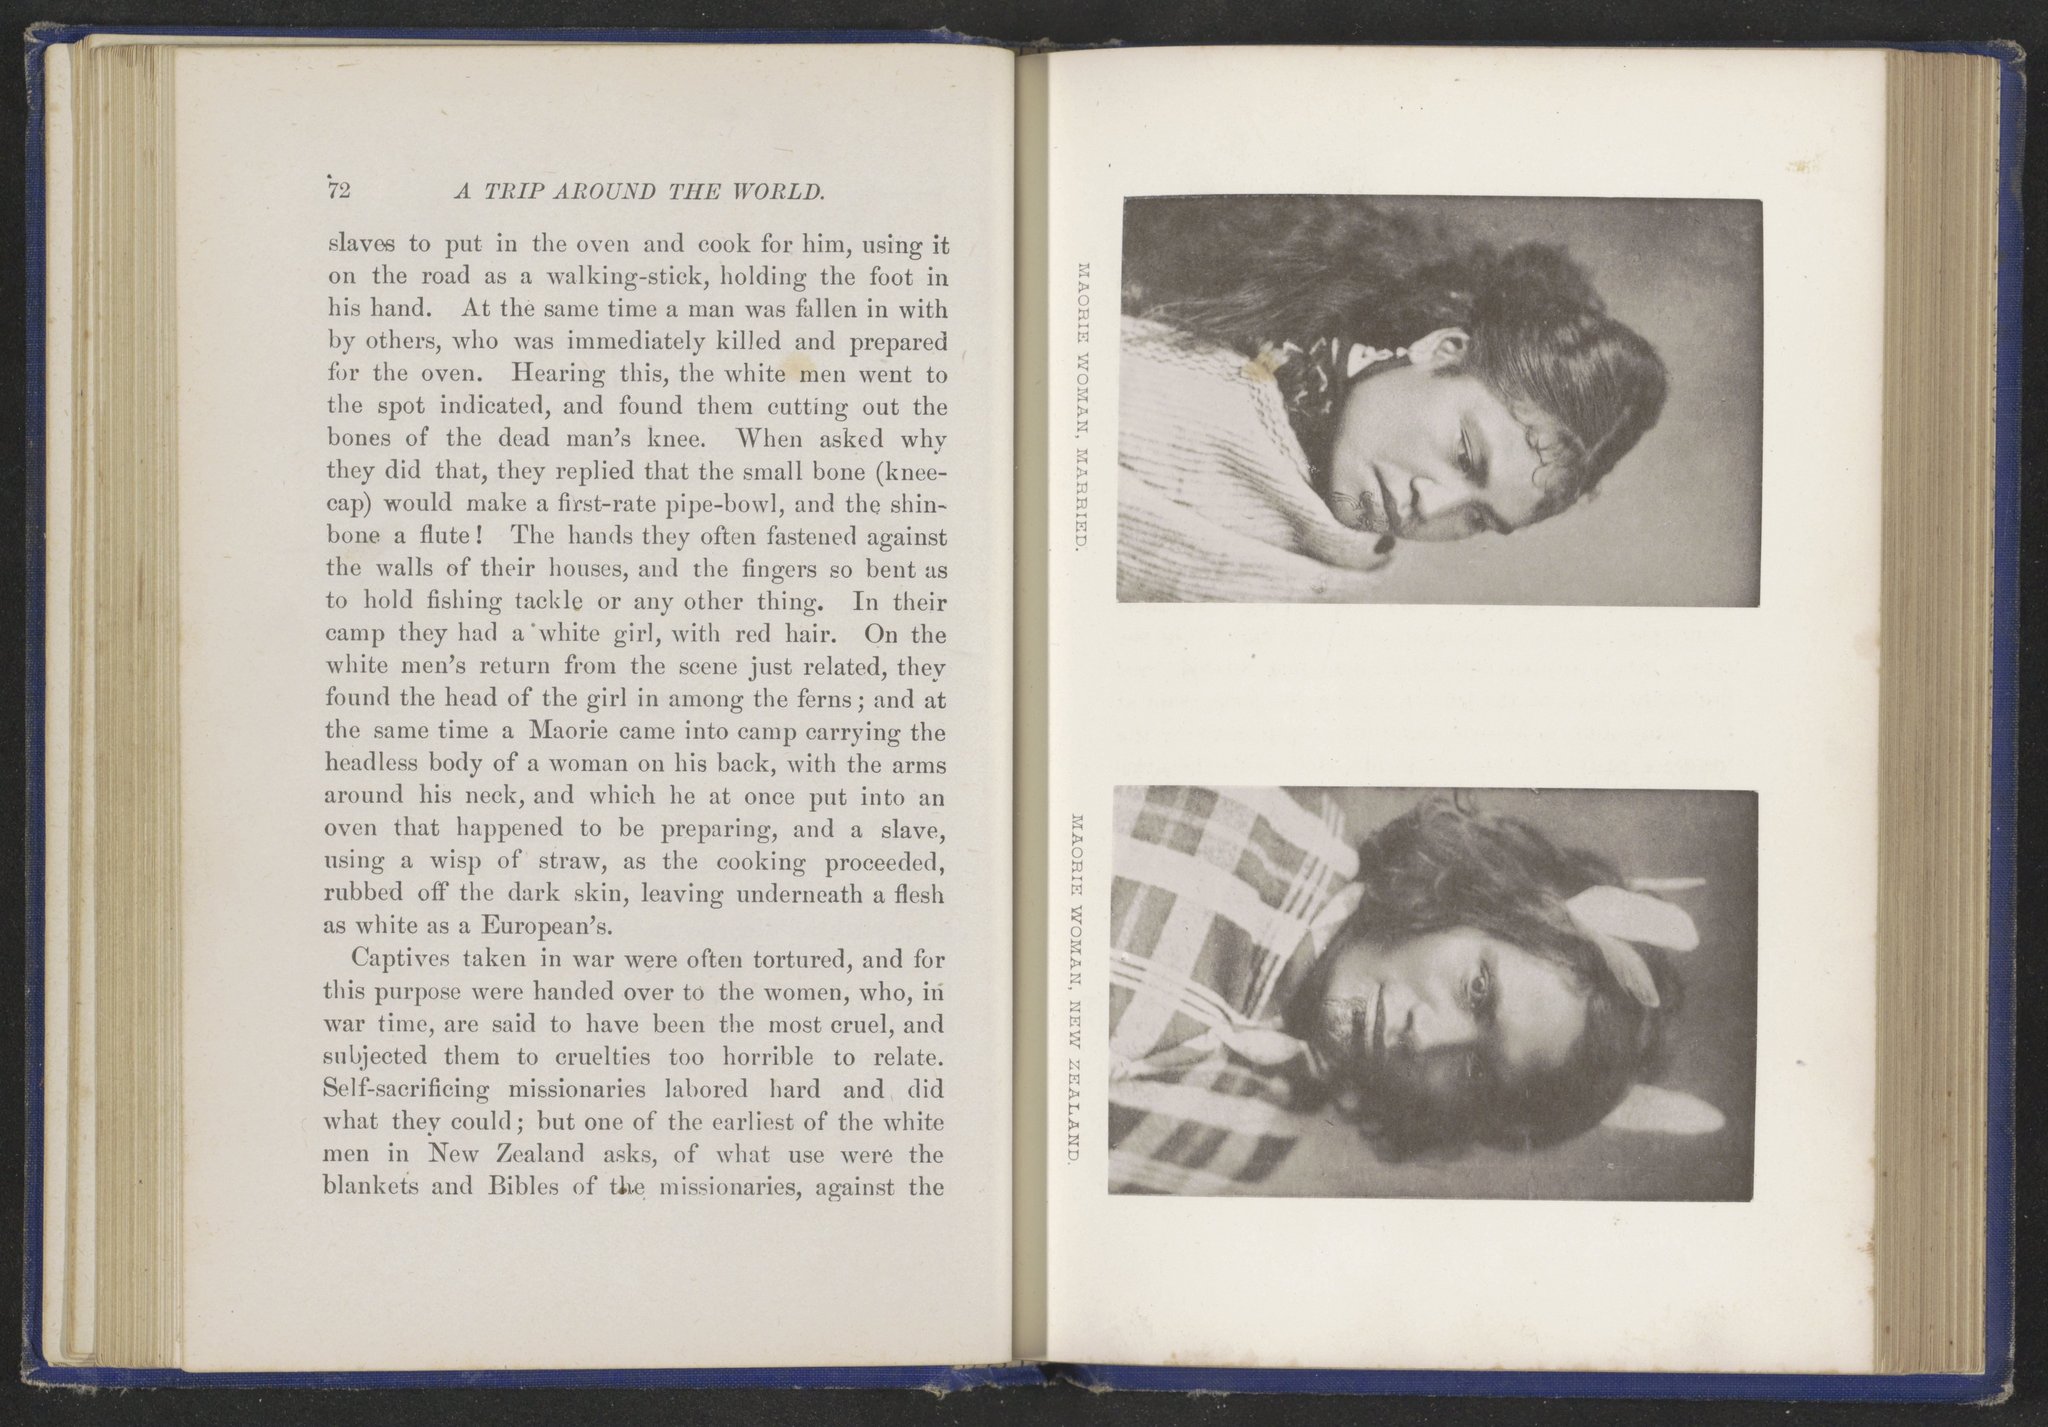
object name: photomechanical print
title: Maorie woman, married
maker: Anonymous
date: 1870-1882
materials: paper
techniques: photograph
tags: tattoo, adult woman (+ sideview, profile), adult woman (+ front view)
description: Links een vrouw in zijaanzicht, rechts een vrouw in vooraanzicht.